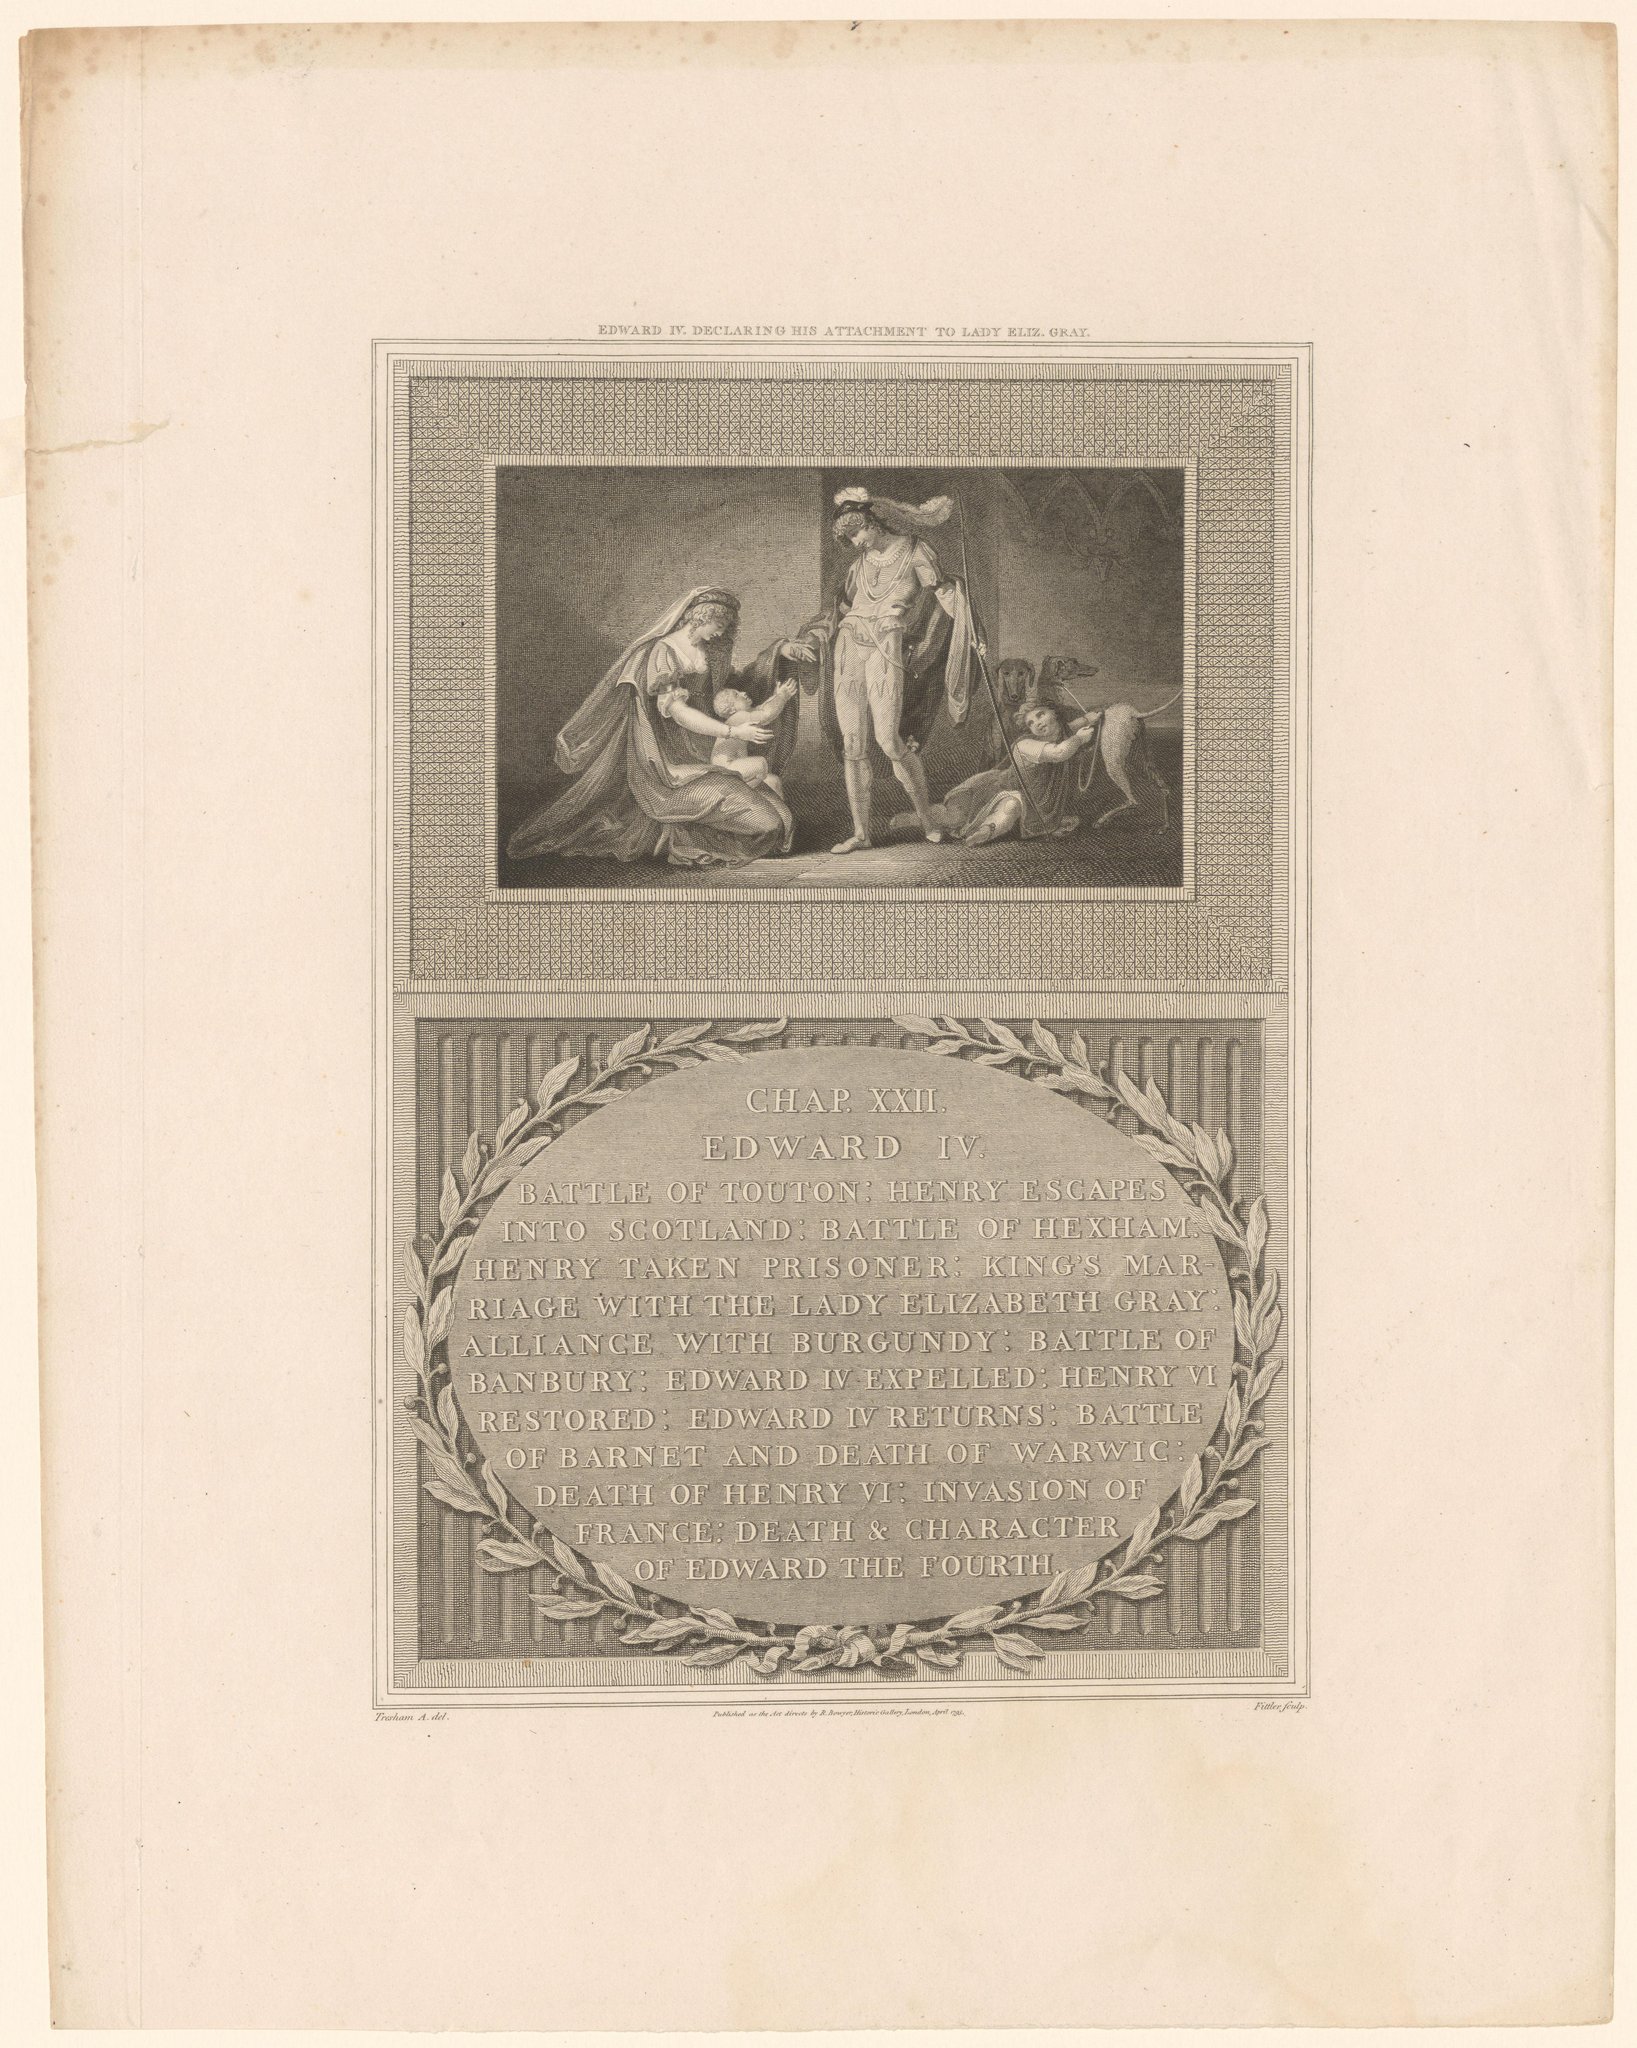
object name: print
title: Edward IV, koning van Engeland, met Elizabeth Woodville en kinderen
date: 1704-1795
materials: paper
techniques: engraving, etching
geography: london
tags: london, second marriage (of widow or widower), historical persons, king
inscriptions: collector's mark: Lugt 2228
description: Deze prent is gebruikt in: The History of England. Londen: Robert Bowyer, 1795. Deze editie is gebaseerd op David Hume's uitgave van 'The History of England', waarvan het eerste deel verscheen in 1754 en het laatste in 1762.